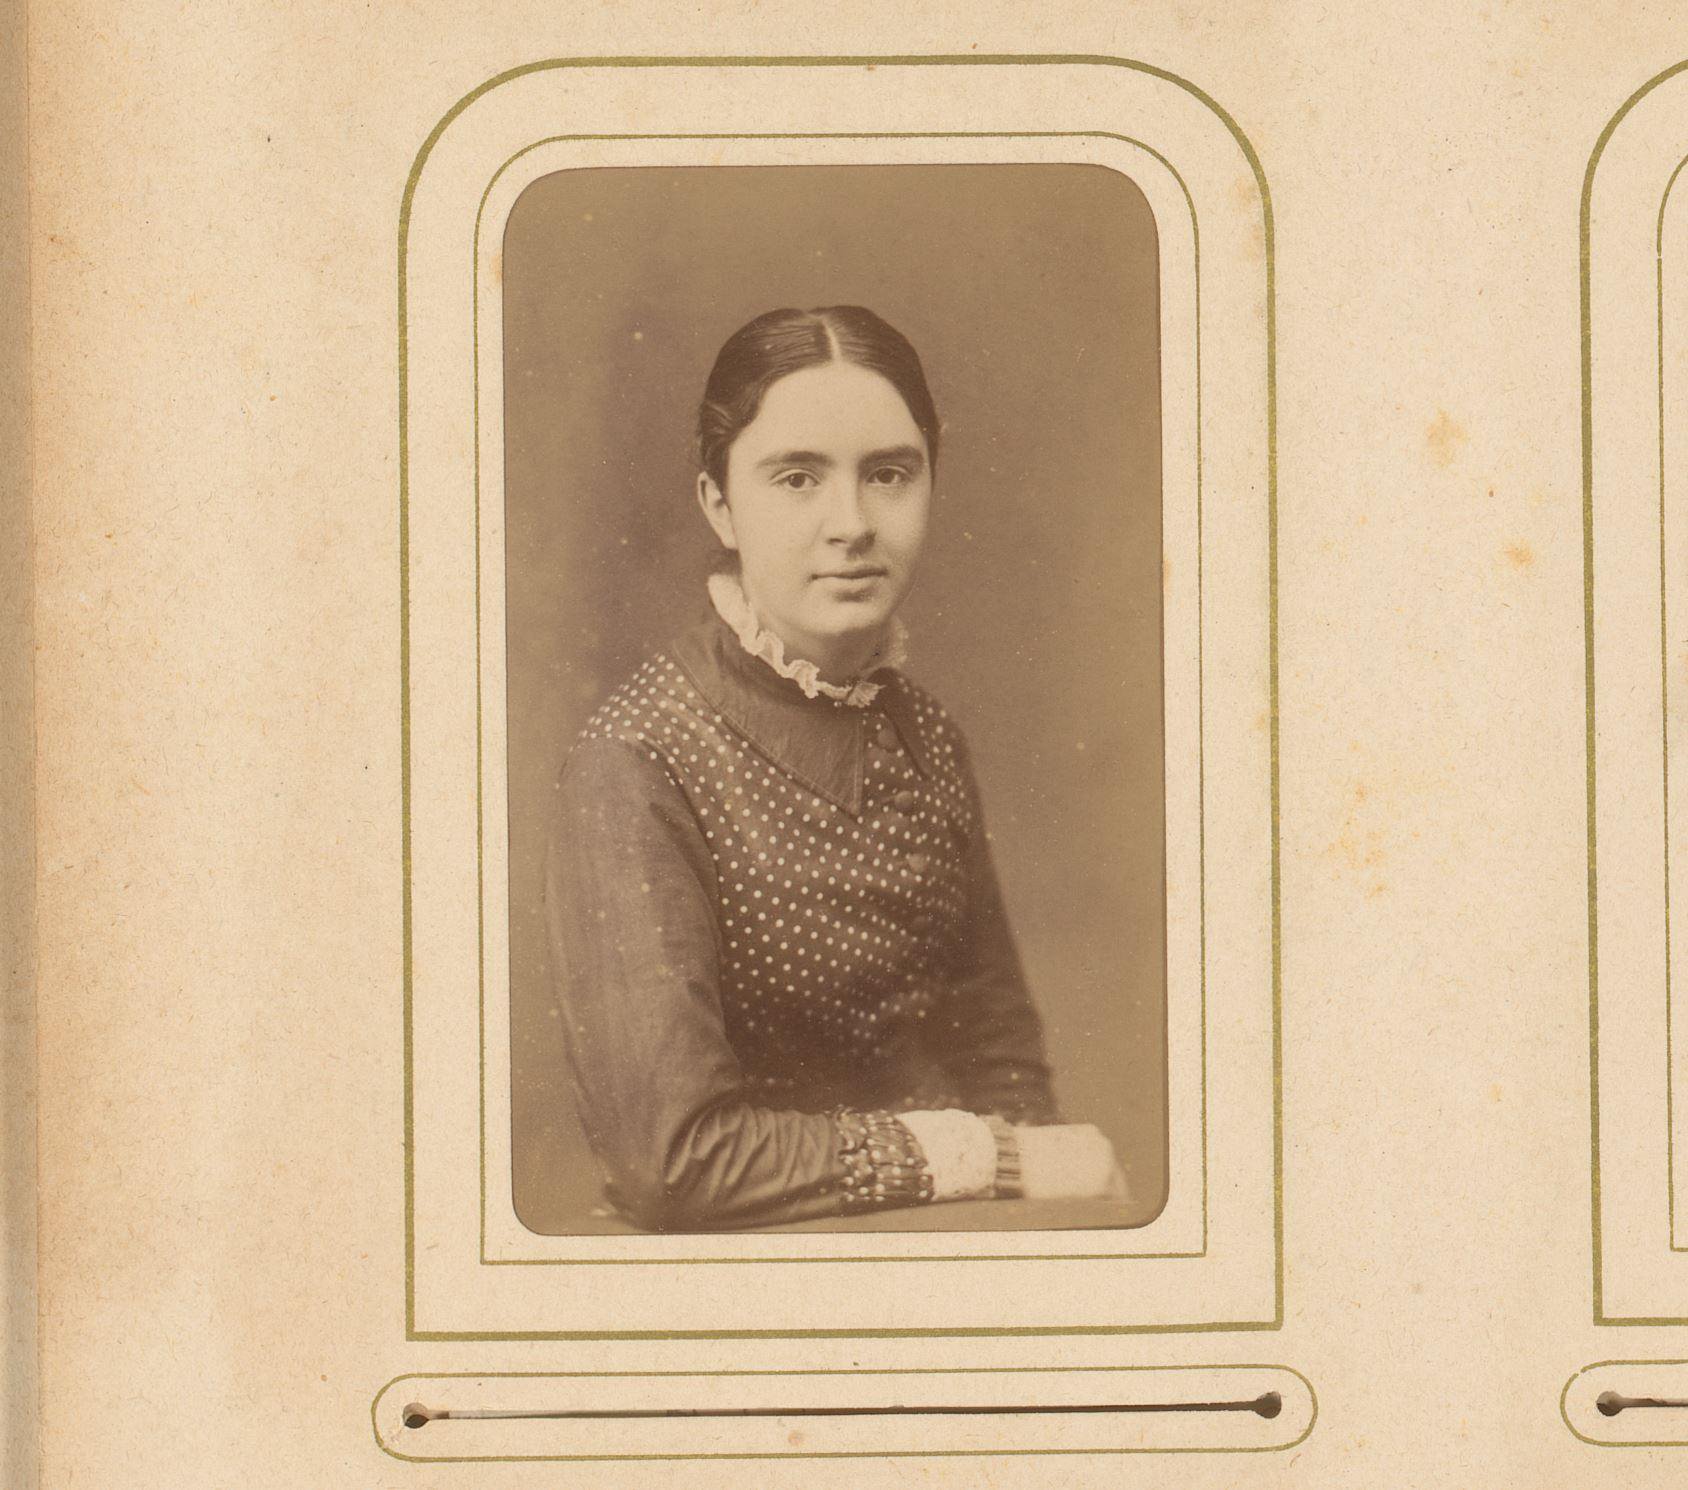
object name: album leaf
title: Portret van een jonge vrouw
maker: dirk niekerk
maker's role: fotograaf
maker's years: 1824-1881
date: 1879-1881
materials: cardboard, photographic support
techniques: albumen print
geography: amsterdam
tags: adolescent, young woman, maiden, historical persons - bb - woman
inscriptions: inscription: ‘Nationale Tentoonstelling 1875/ VERGULD ZILVER/ (...)/ Internationale Tentoonstelling 1877/ PHOTOGRAPHIE-INSTANTANÉ/ D. NIEKERK/ Photograaf van Wijlen Z.K.H. Prins Hendrik der Nederlanden./ ALLÉÉN/ Gevestig Baangracht tusschen/ Leidsche Plein en Kruisstraat 248./ AMSTERDAM.’